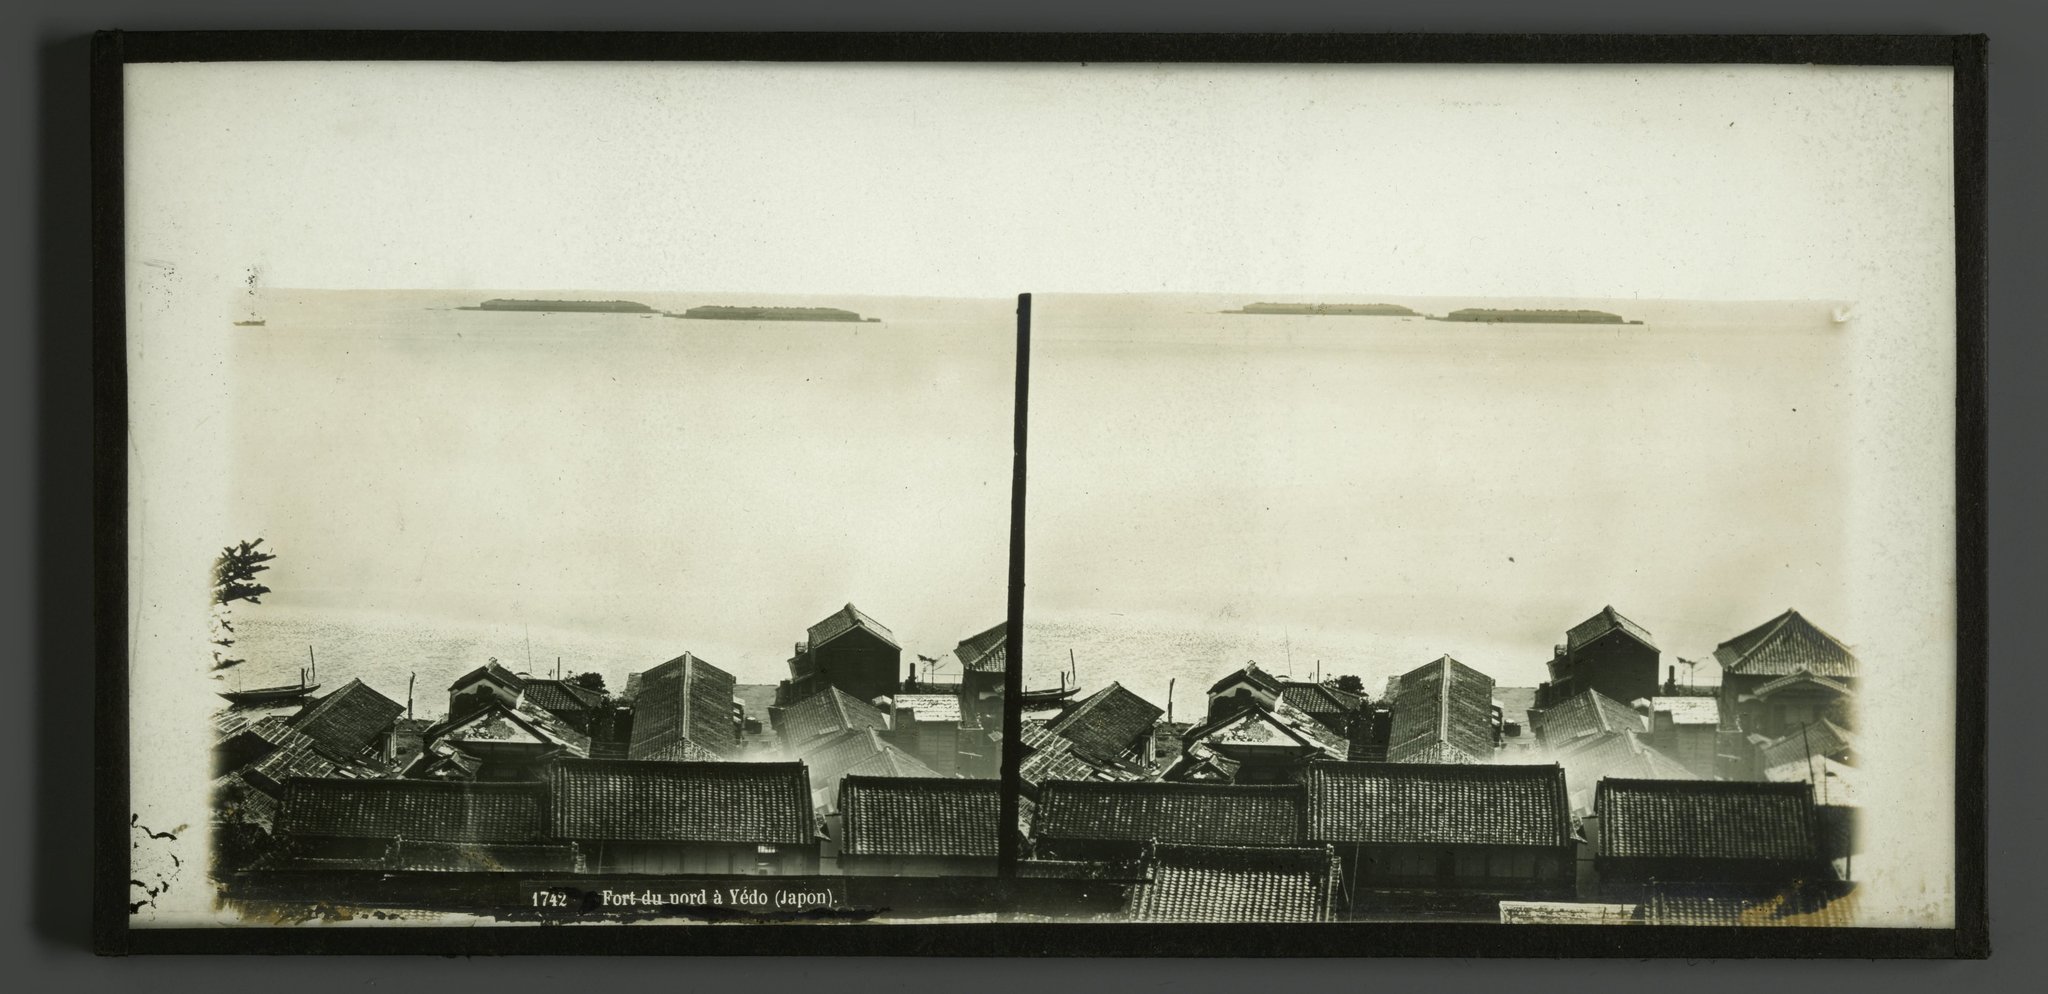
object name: photograph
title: Fort du nord a Yedo (Japon)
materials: glass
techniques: slide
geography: paris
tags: ocean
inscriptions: number: ‘1742’